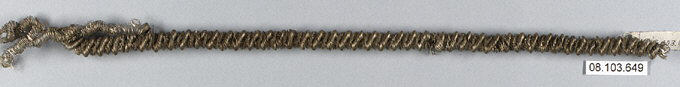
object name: cord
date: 1801-1900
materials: metal thread